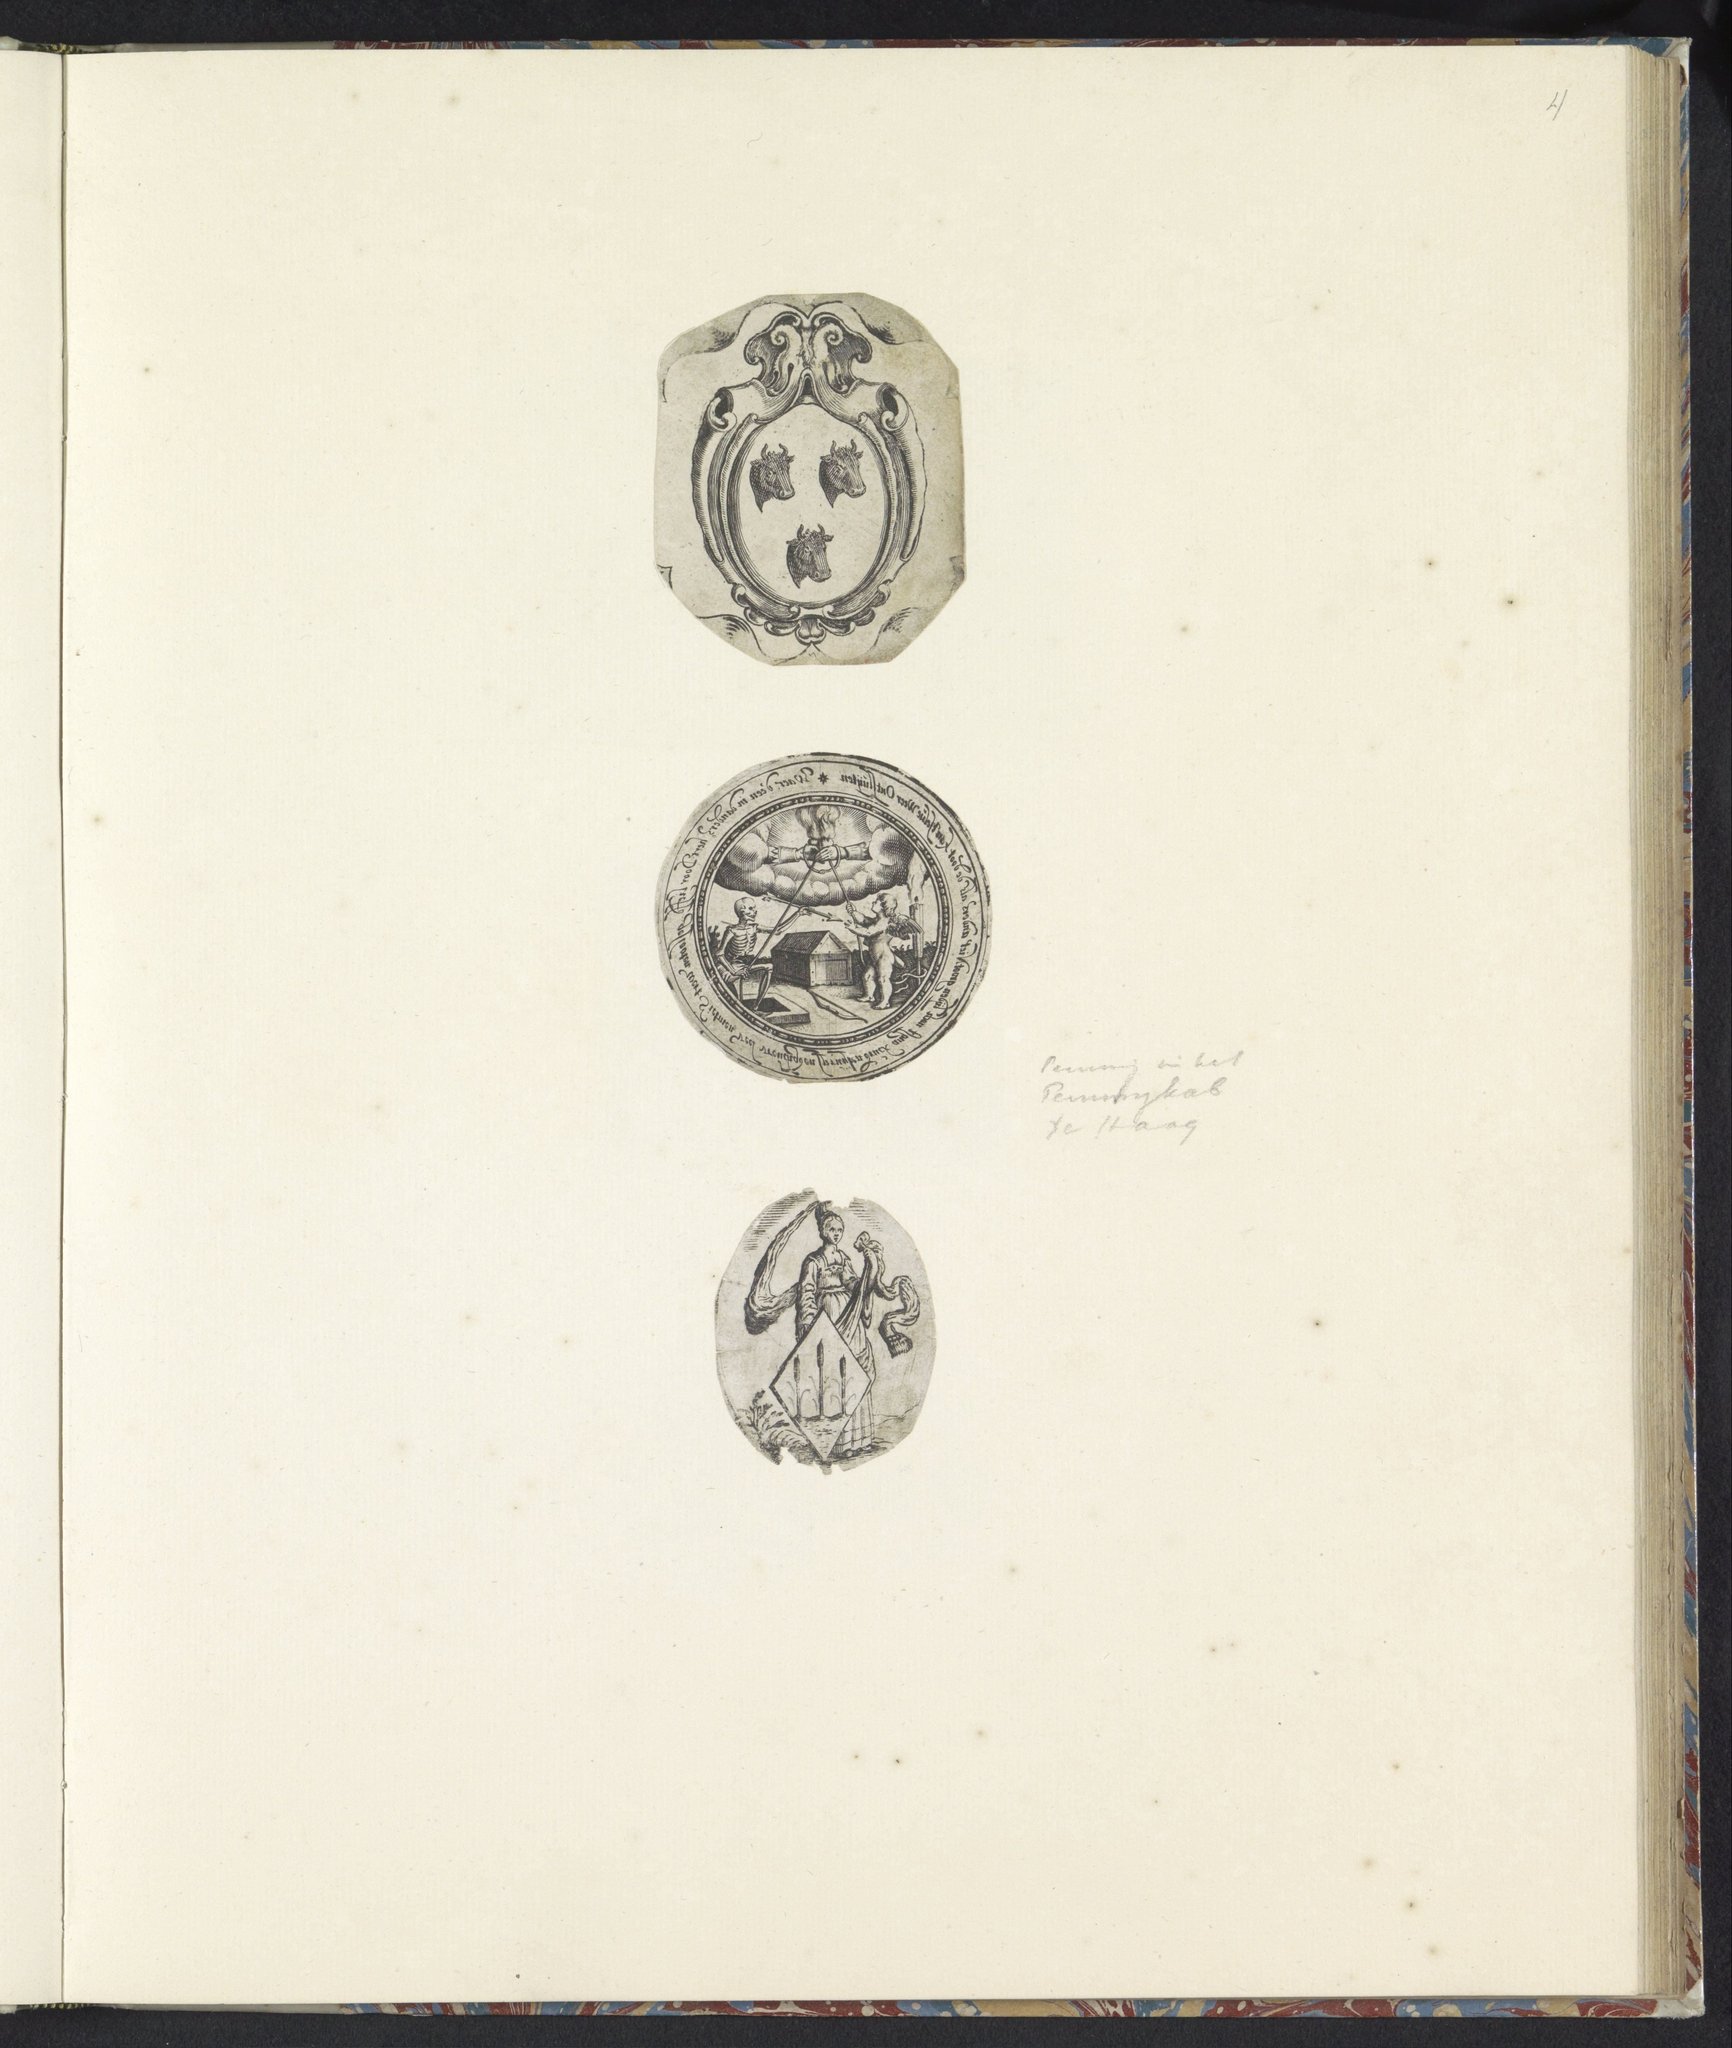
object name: print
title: Twee wapens en een huwelijkspenning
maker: Anonymous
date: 1550-1650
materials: paper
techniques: engraving, etching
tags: personifications of death; 'morte' (ripa), (story of) cupid, amor (eros), armorial bearing, heraldry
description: Drie voorstellingen op een albumblad. Bovenaan een cartouche met drie ossenkoppen naar rechts. Onderaan een jonkvrouw met een schild met drie korenaren. De voorstelling in het midden is gedrukt van een huwelijkspenning. De tekst is spiegelbeeldig: Waer d'een in d'anders hert door lieffd geslooten wert, Siet men veel vreuchgden spruyten ... Daarbij twee handen in de wolken met een brandend hart. De handen worden omsloten door een touw, vastgehouden door de Dood en Amor. De Dood bedreigt Amor met een pijl. De prenten maken deel uit van een album.